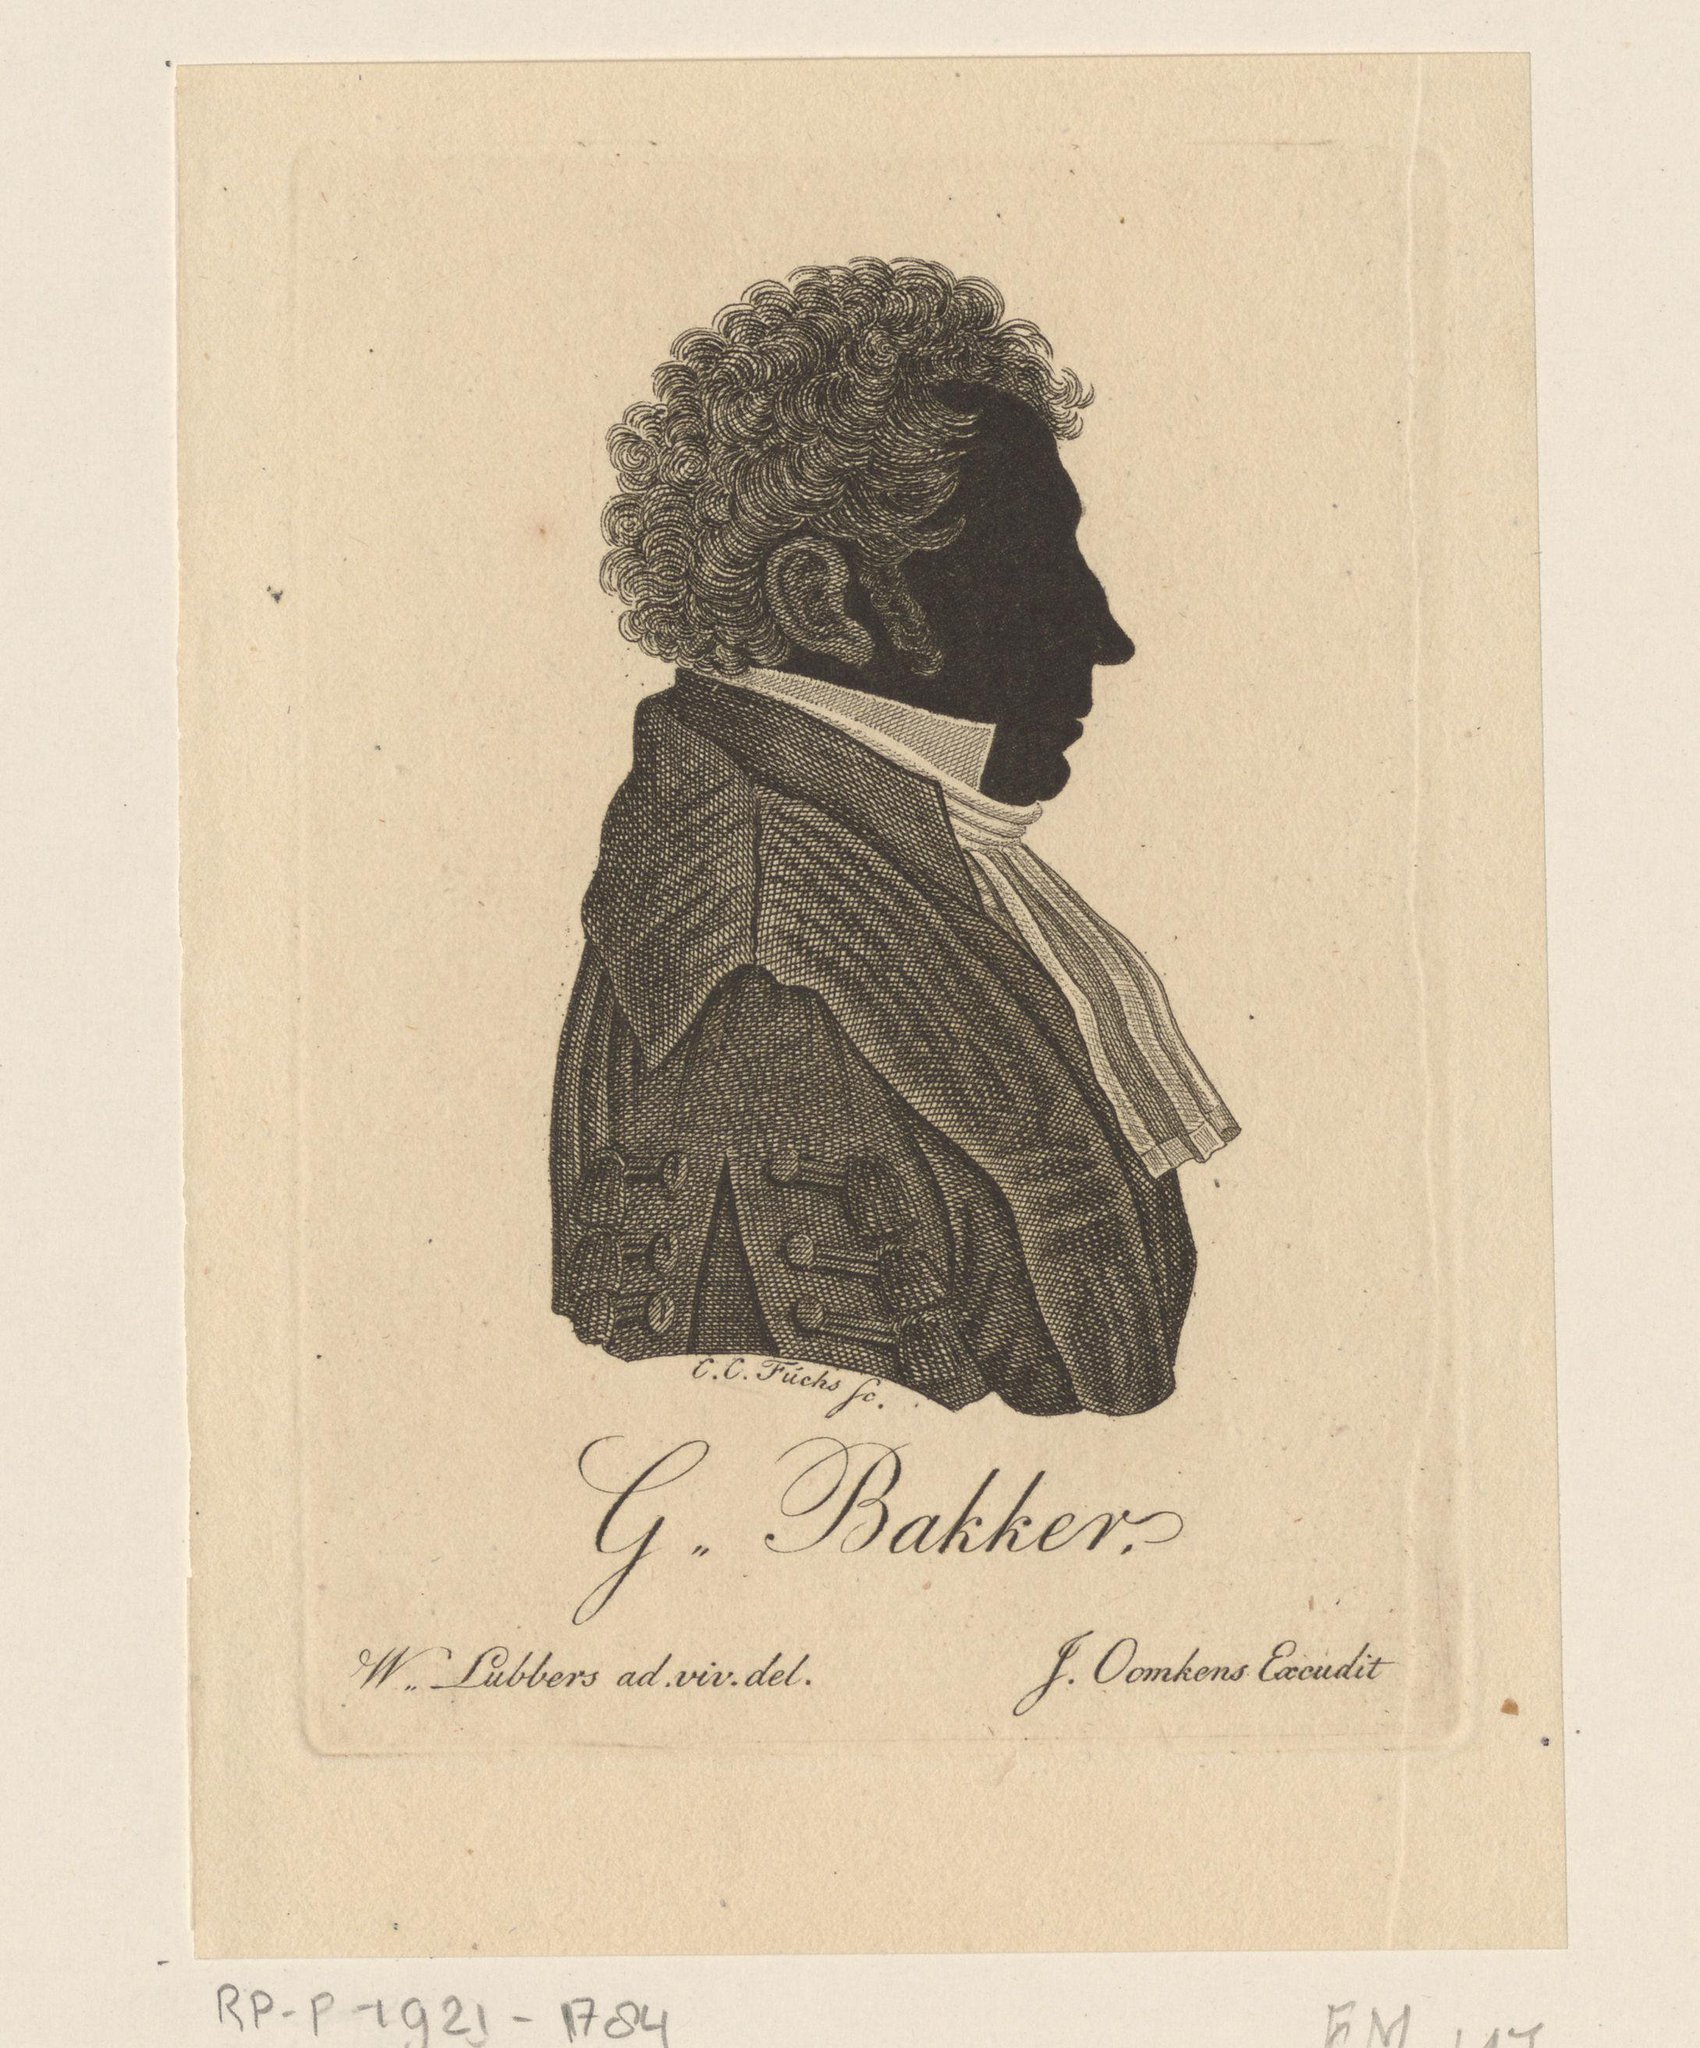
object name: print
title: Silhouetportret van G. Bakker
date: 1828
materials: paper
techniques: engraving, etching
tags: historical persons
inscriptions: collector's mark: Lugt 2233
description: Prent uit: Almanak der Akademie van Groningen. Groningen: Jan Oomkens, 1828.